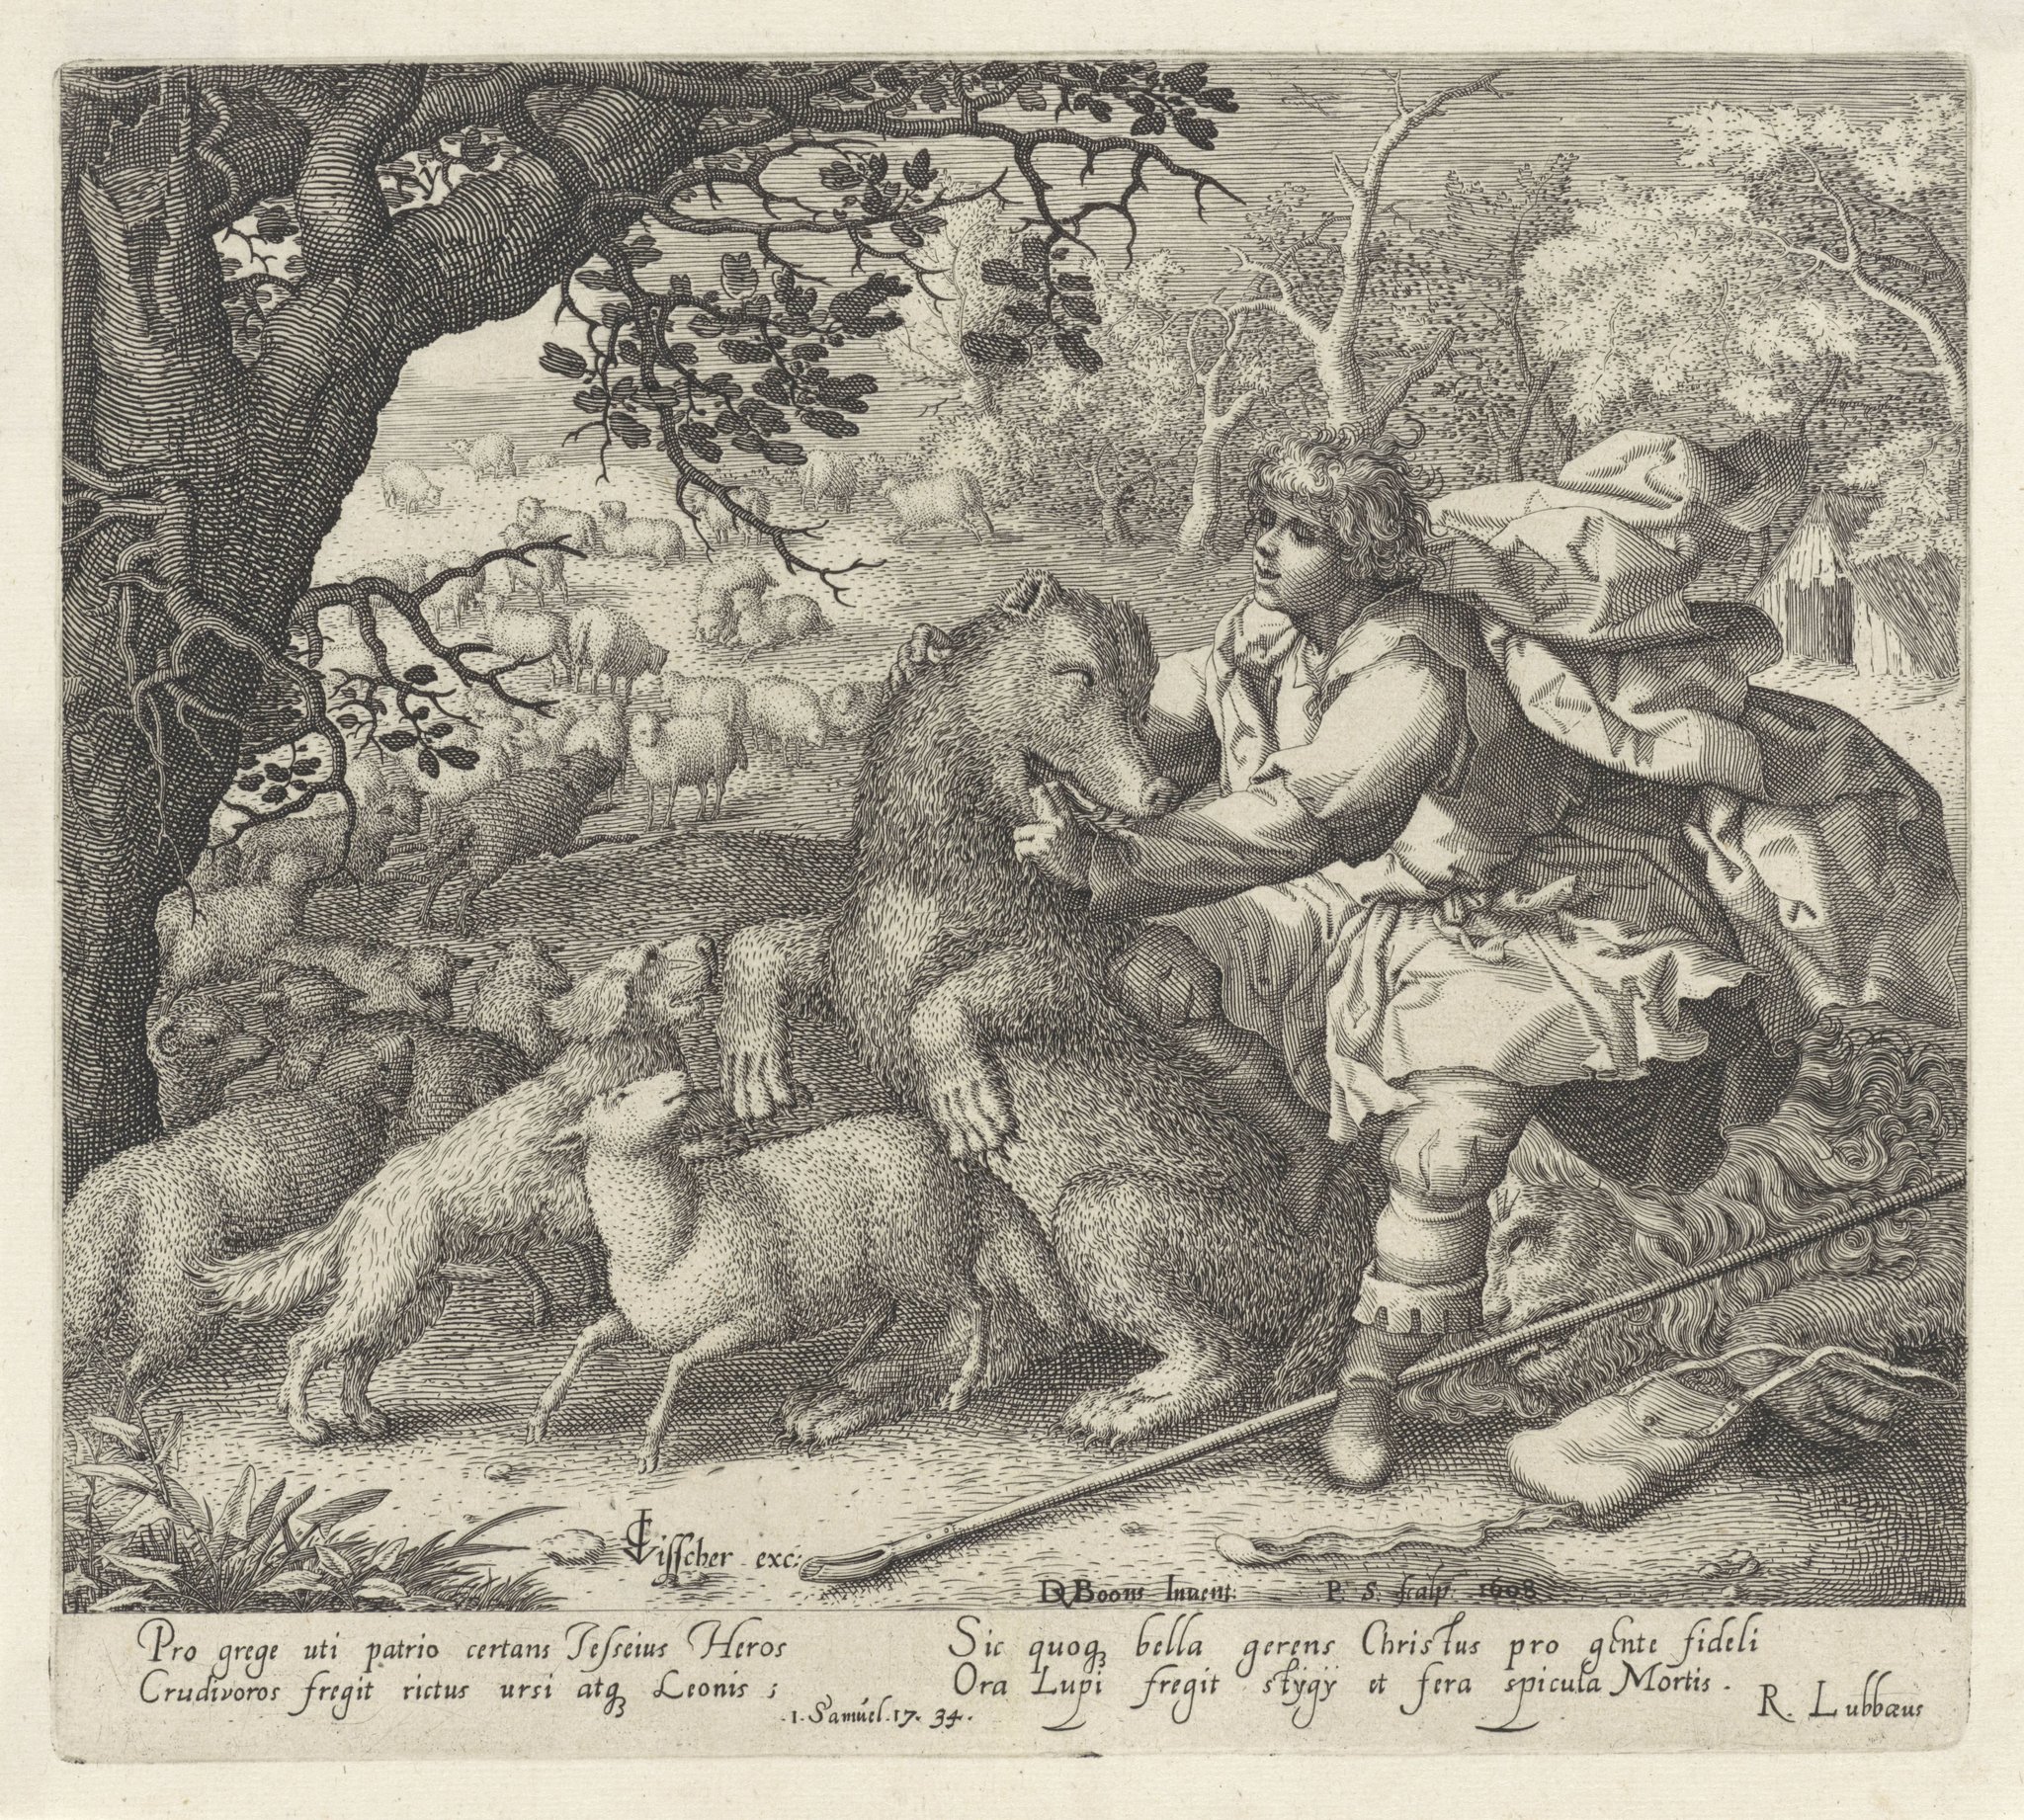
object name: print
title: David met de beer en de leeuw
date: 1608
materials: paper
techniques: engraving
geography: amsterdam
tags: david kills a lion and a bear (or tells saul about it)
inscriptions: collector's mark: Lugt 2228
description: David grijpt met zijn blote handen een beer, die zijn kudde bedreigde. Aan zijn voeten ligt een gedode leeuw. Onder de prent vier versregels in het Latijn en een verwijzing naar 1. Sam. 17.34.